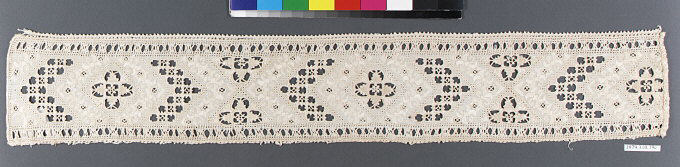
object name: band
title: Bands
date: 1401-1600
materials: linen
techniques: lace